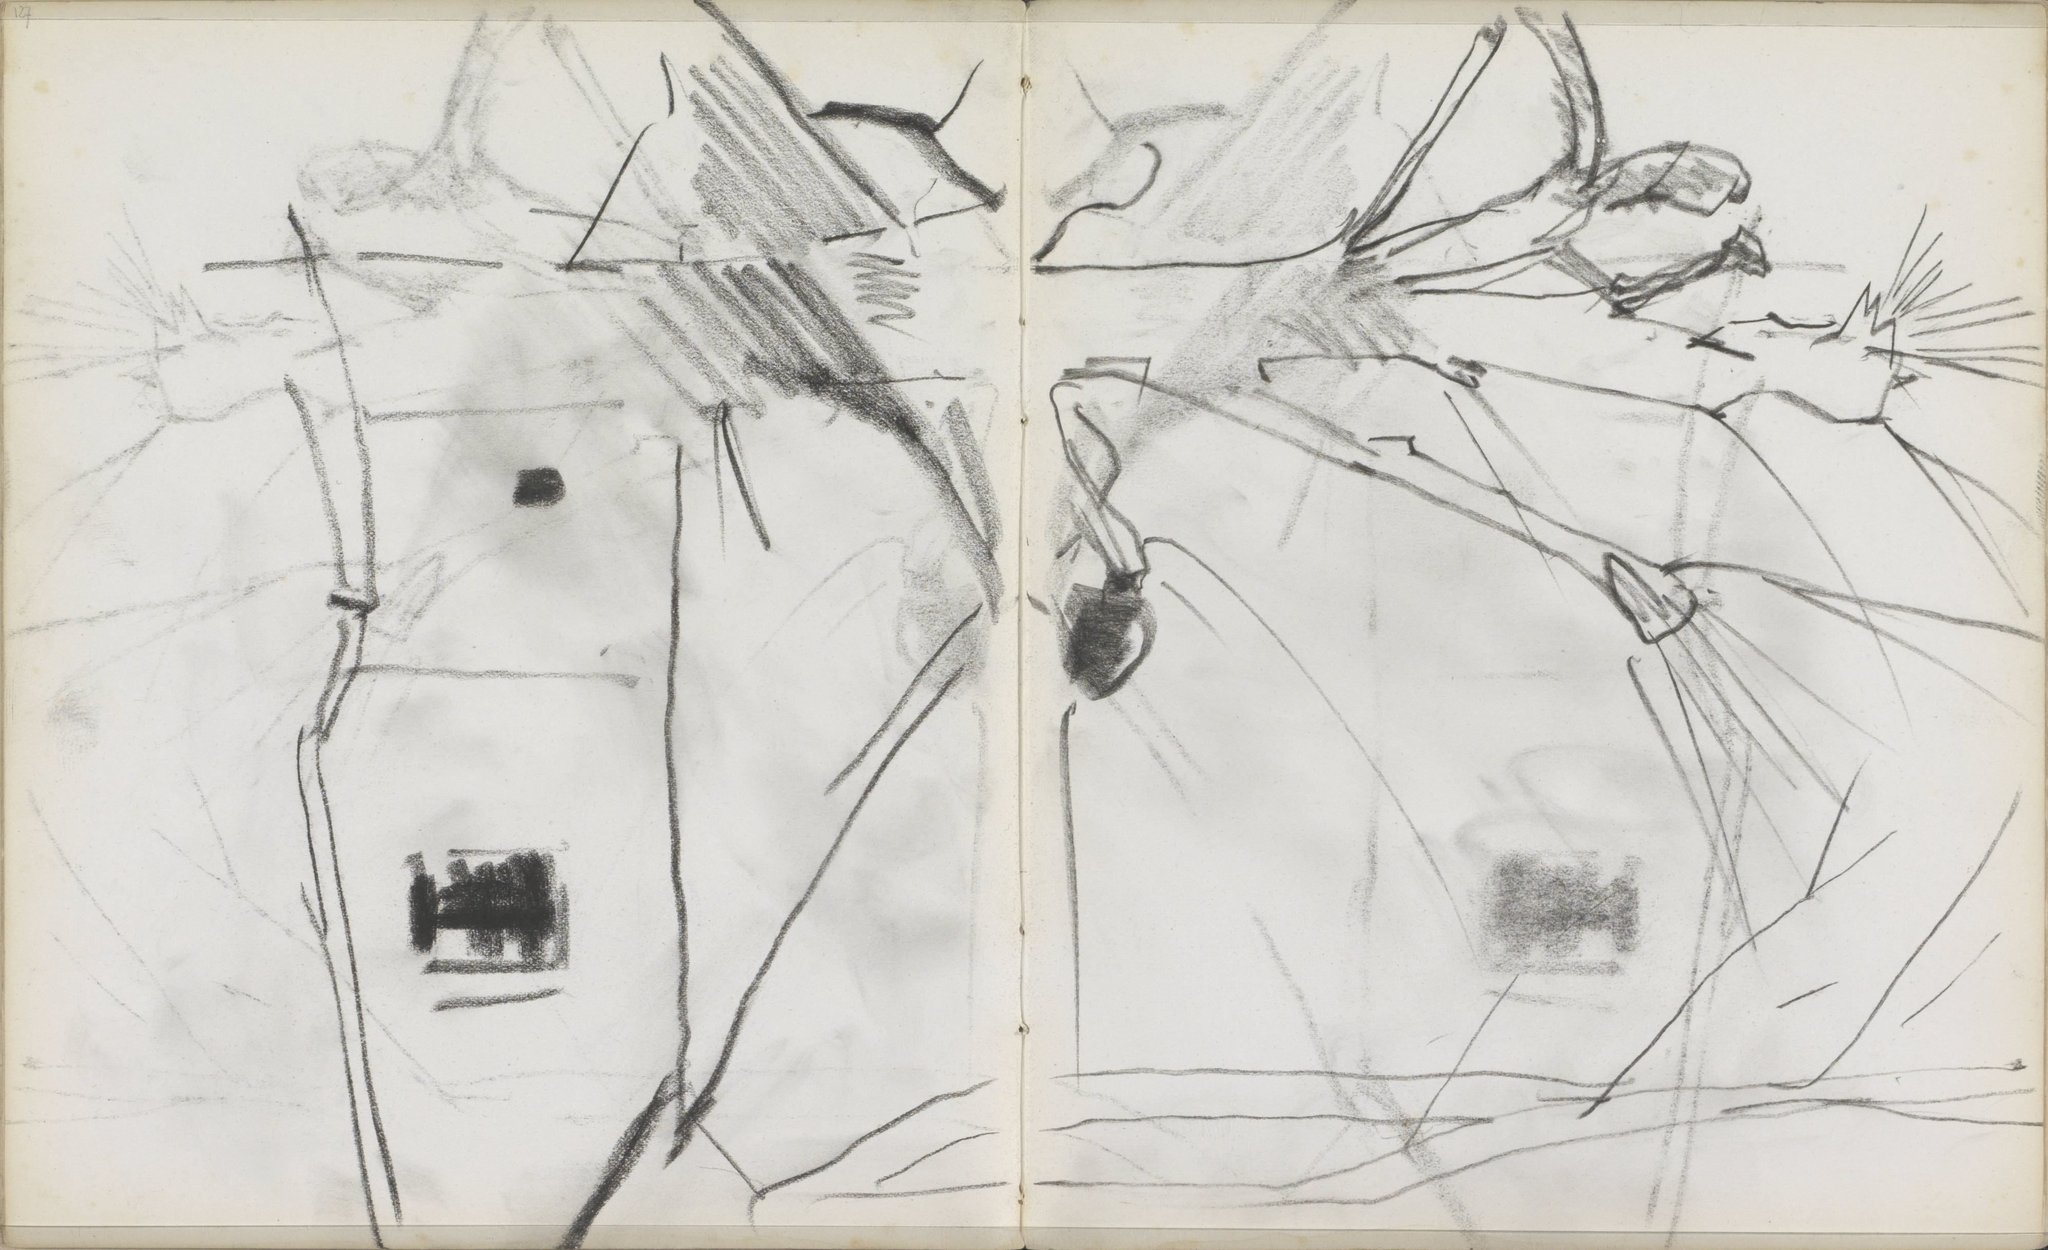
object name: sketchbook leaf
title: Bomen voor een boerderij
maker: george hendrik breitner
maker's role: draughtsman, painter, print maker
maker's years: 1857-1923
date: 1880-1906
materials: chalk, paper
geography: netherlands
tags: trees, farm (building)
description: Pagina 127 en pagina 128 uit een schetsboek met 81 bladen.